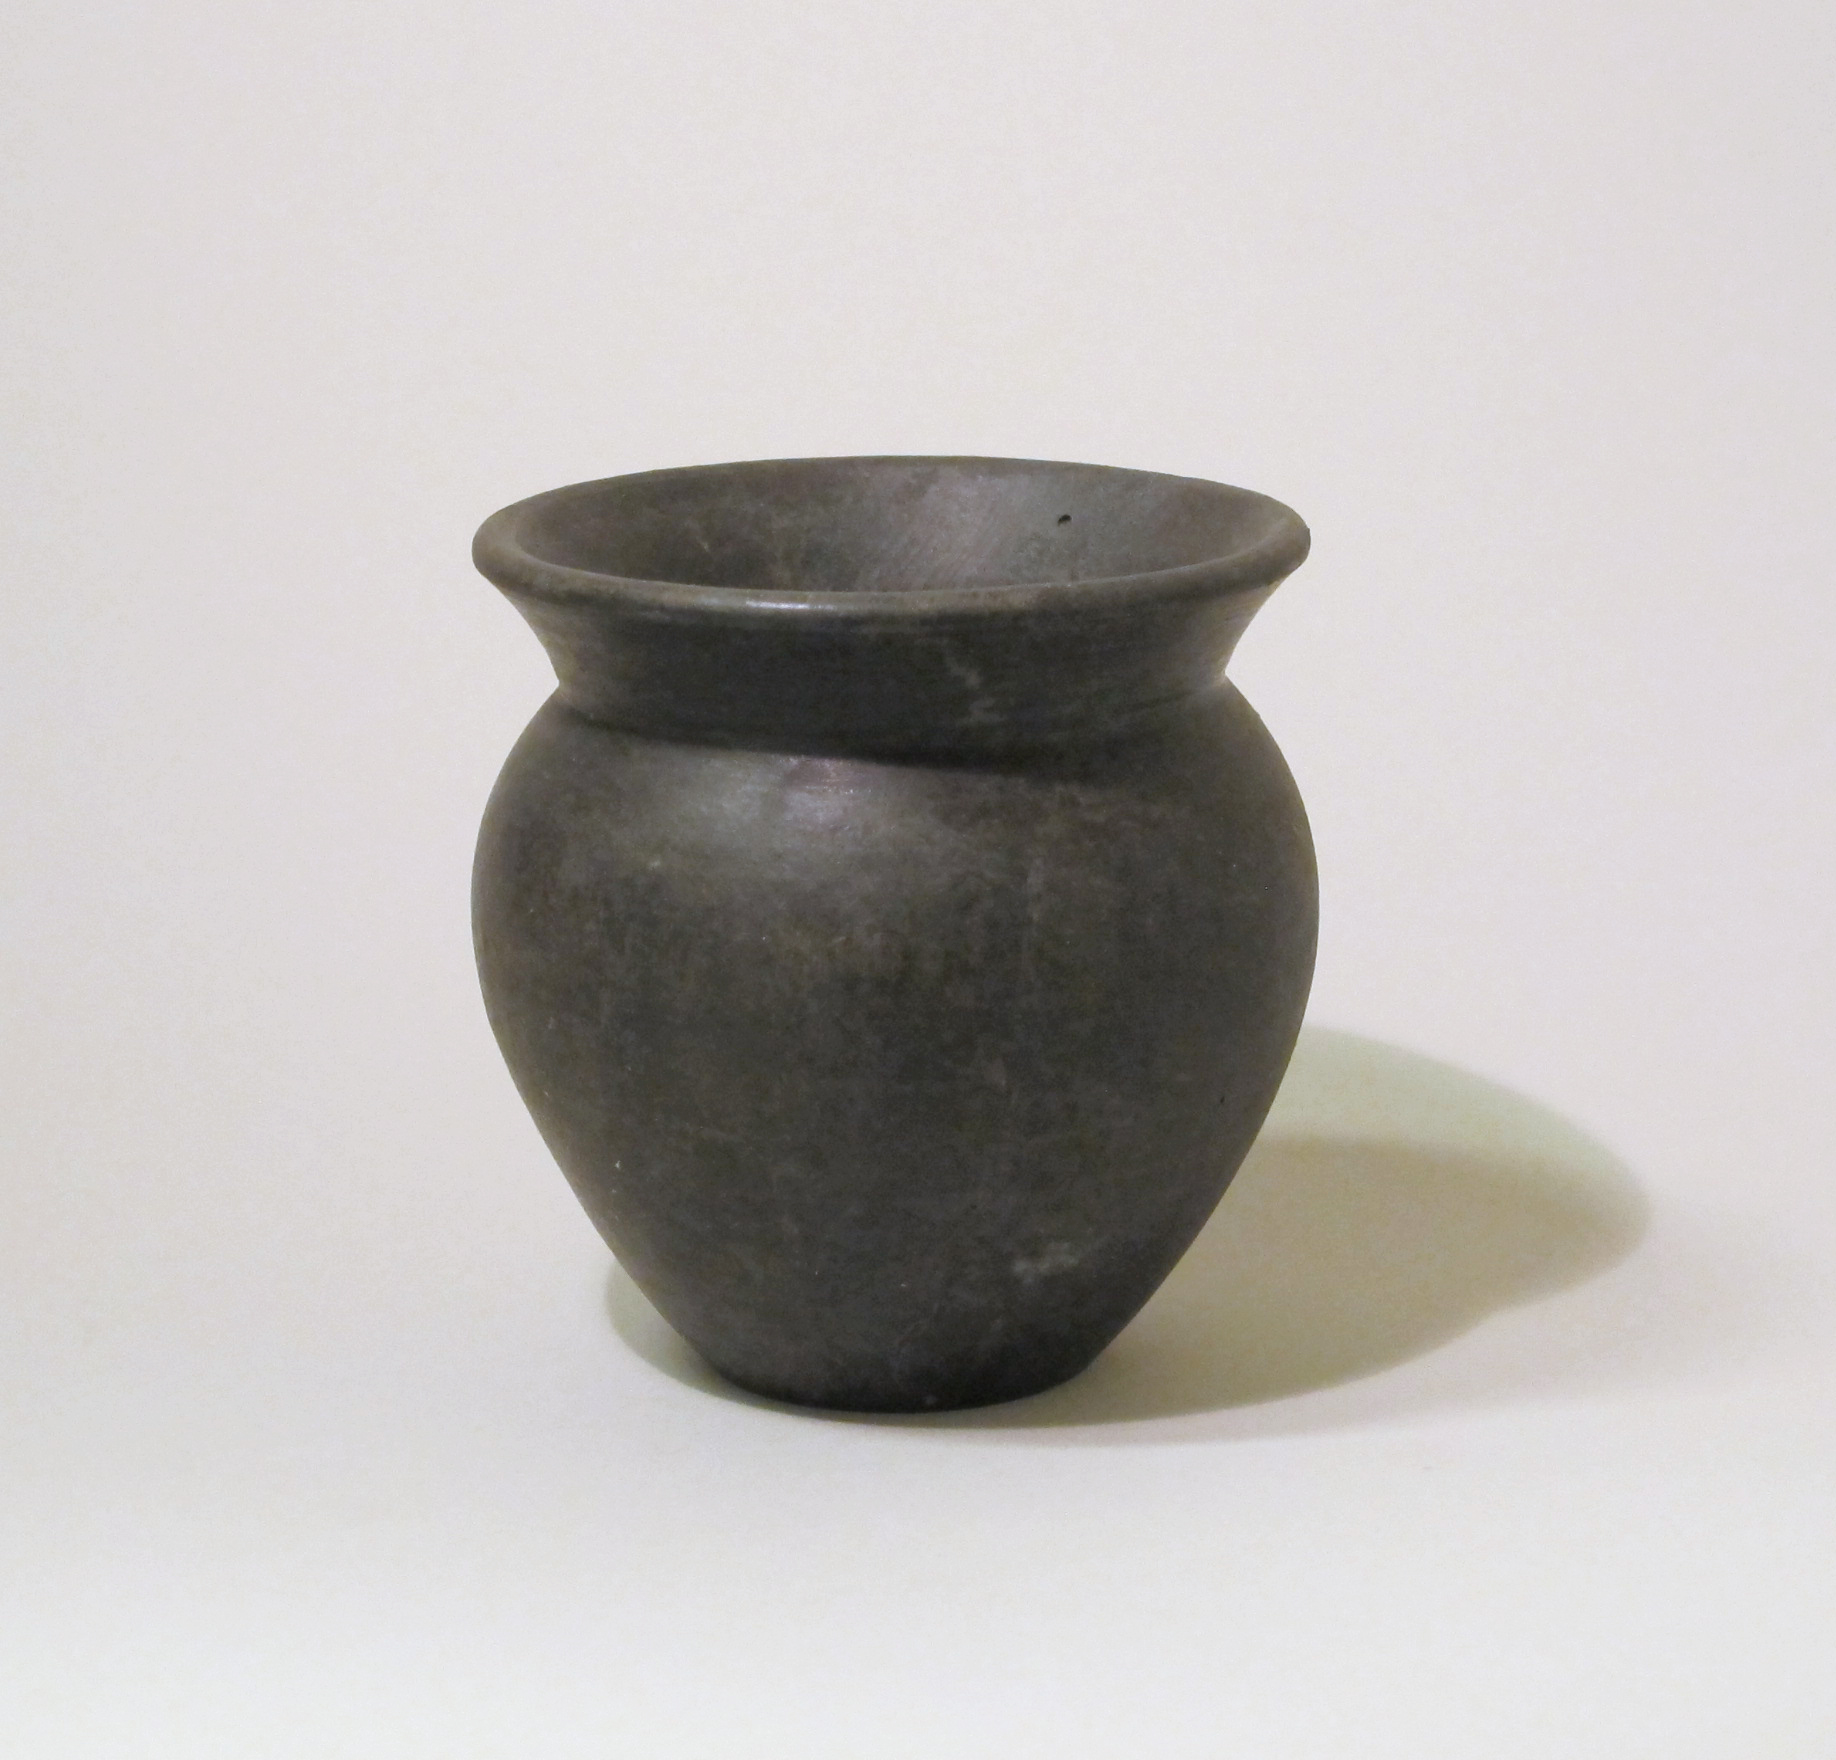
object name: focolare bowl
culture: etruscan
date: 550-501 BCE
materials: terracotta